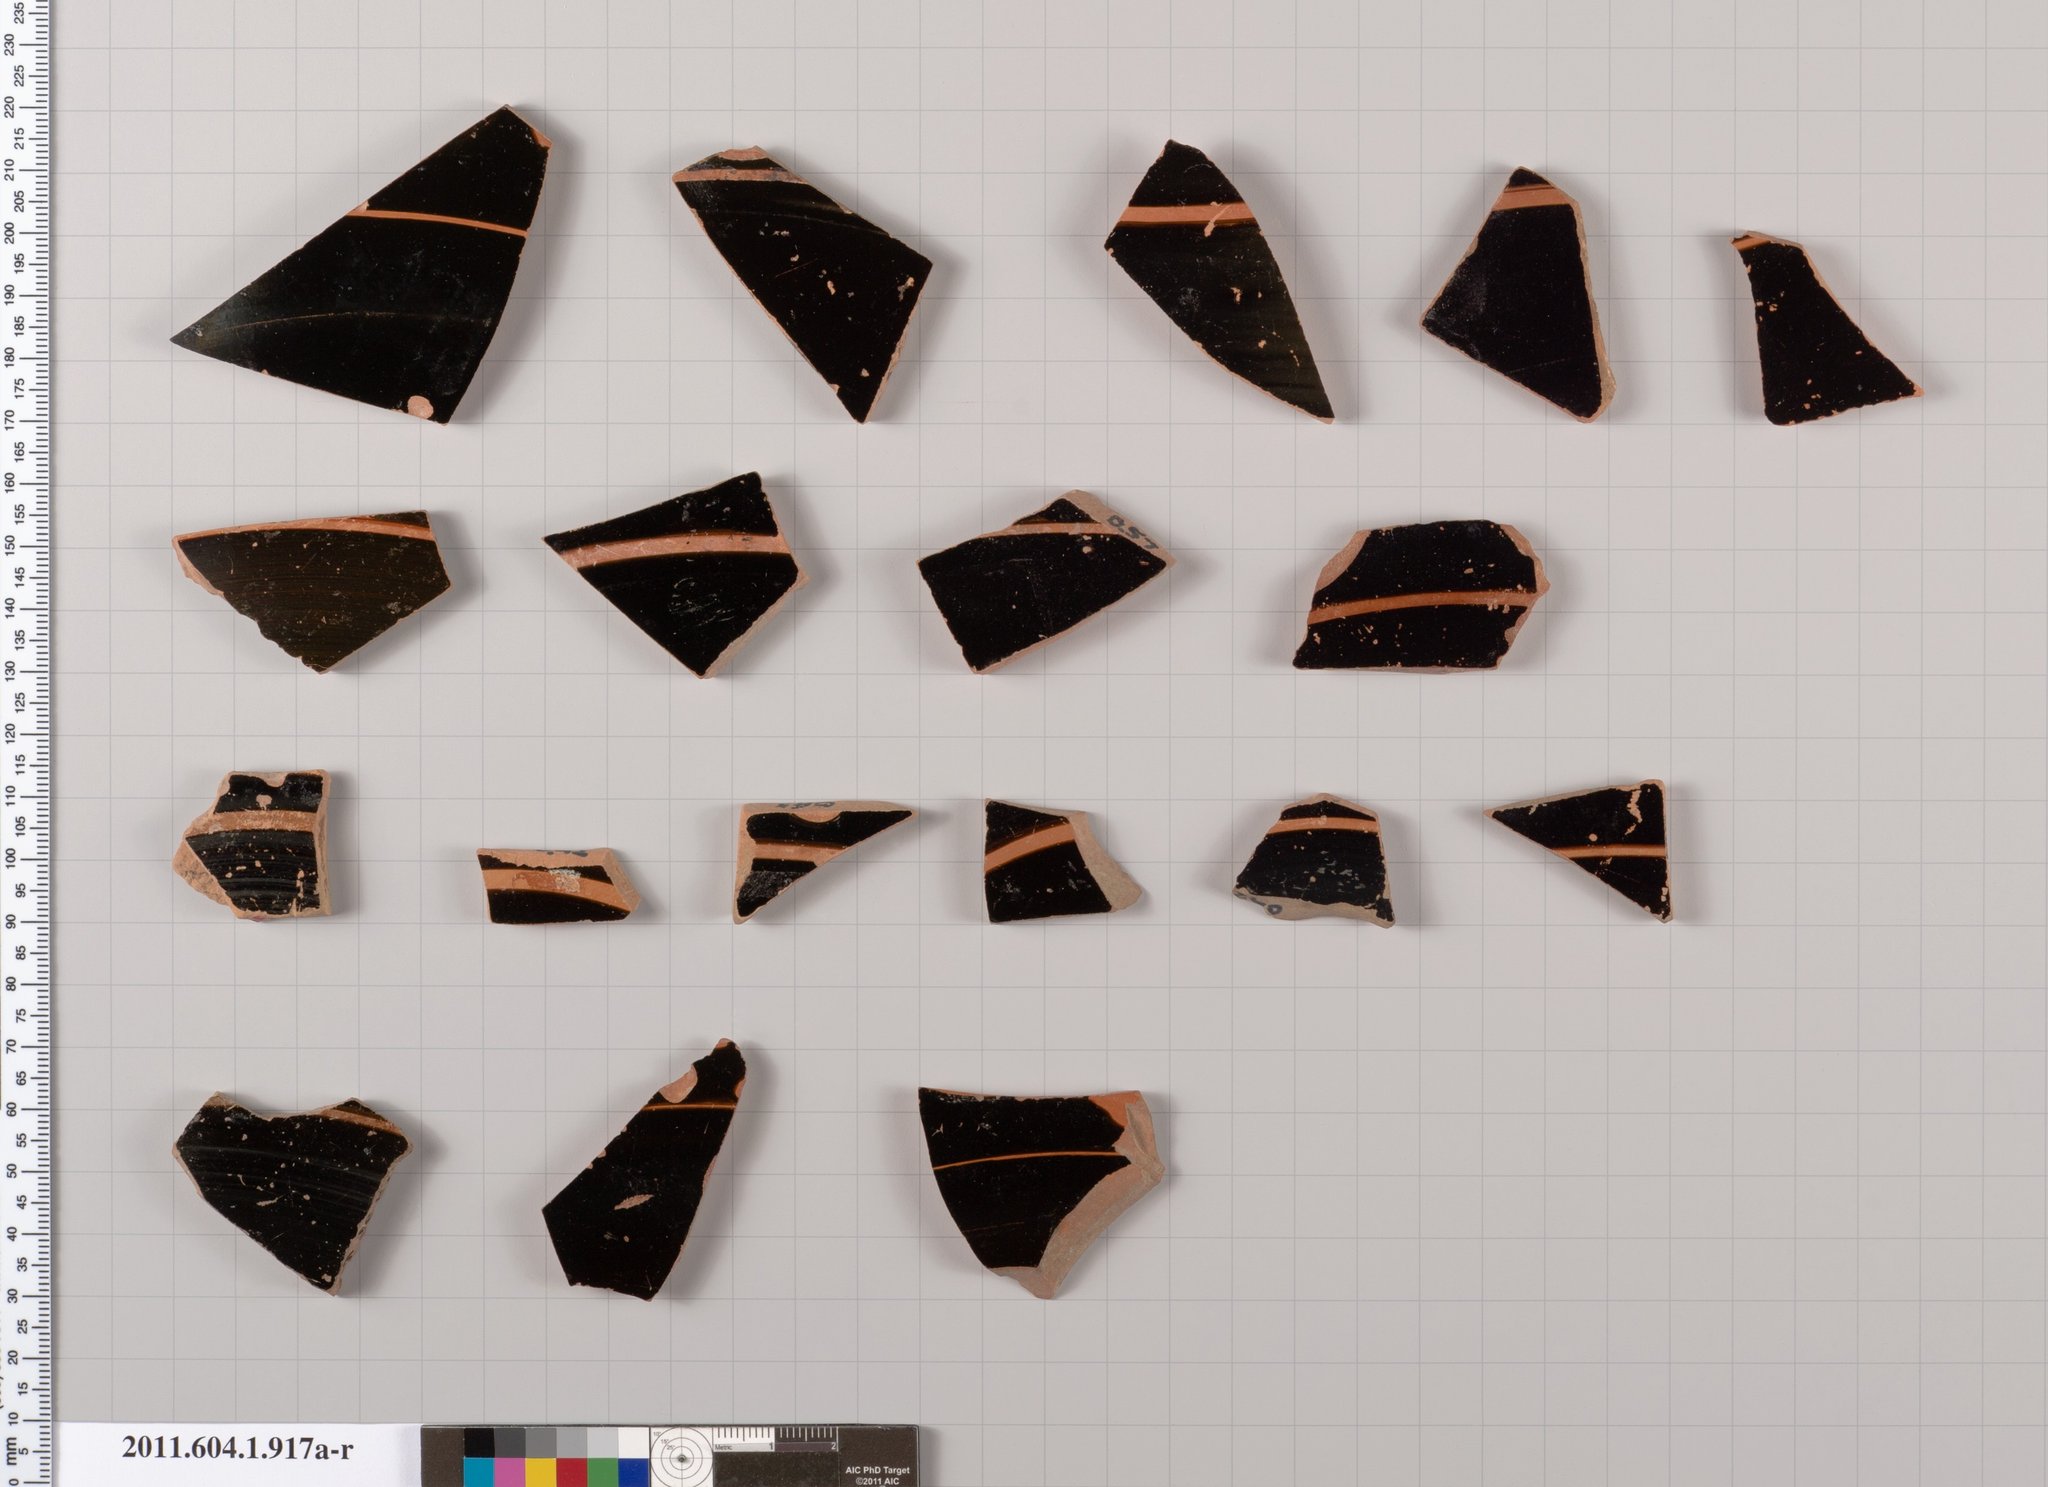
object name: kylix fragment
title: Terracotta fragments of kylikes (drinking cups)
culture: greek, attic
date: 500-401 BCE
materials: terracotta